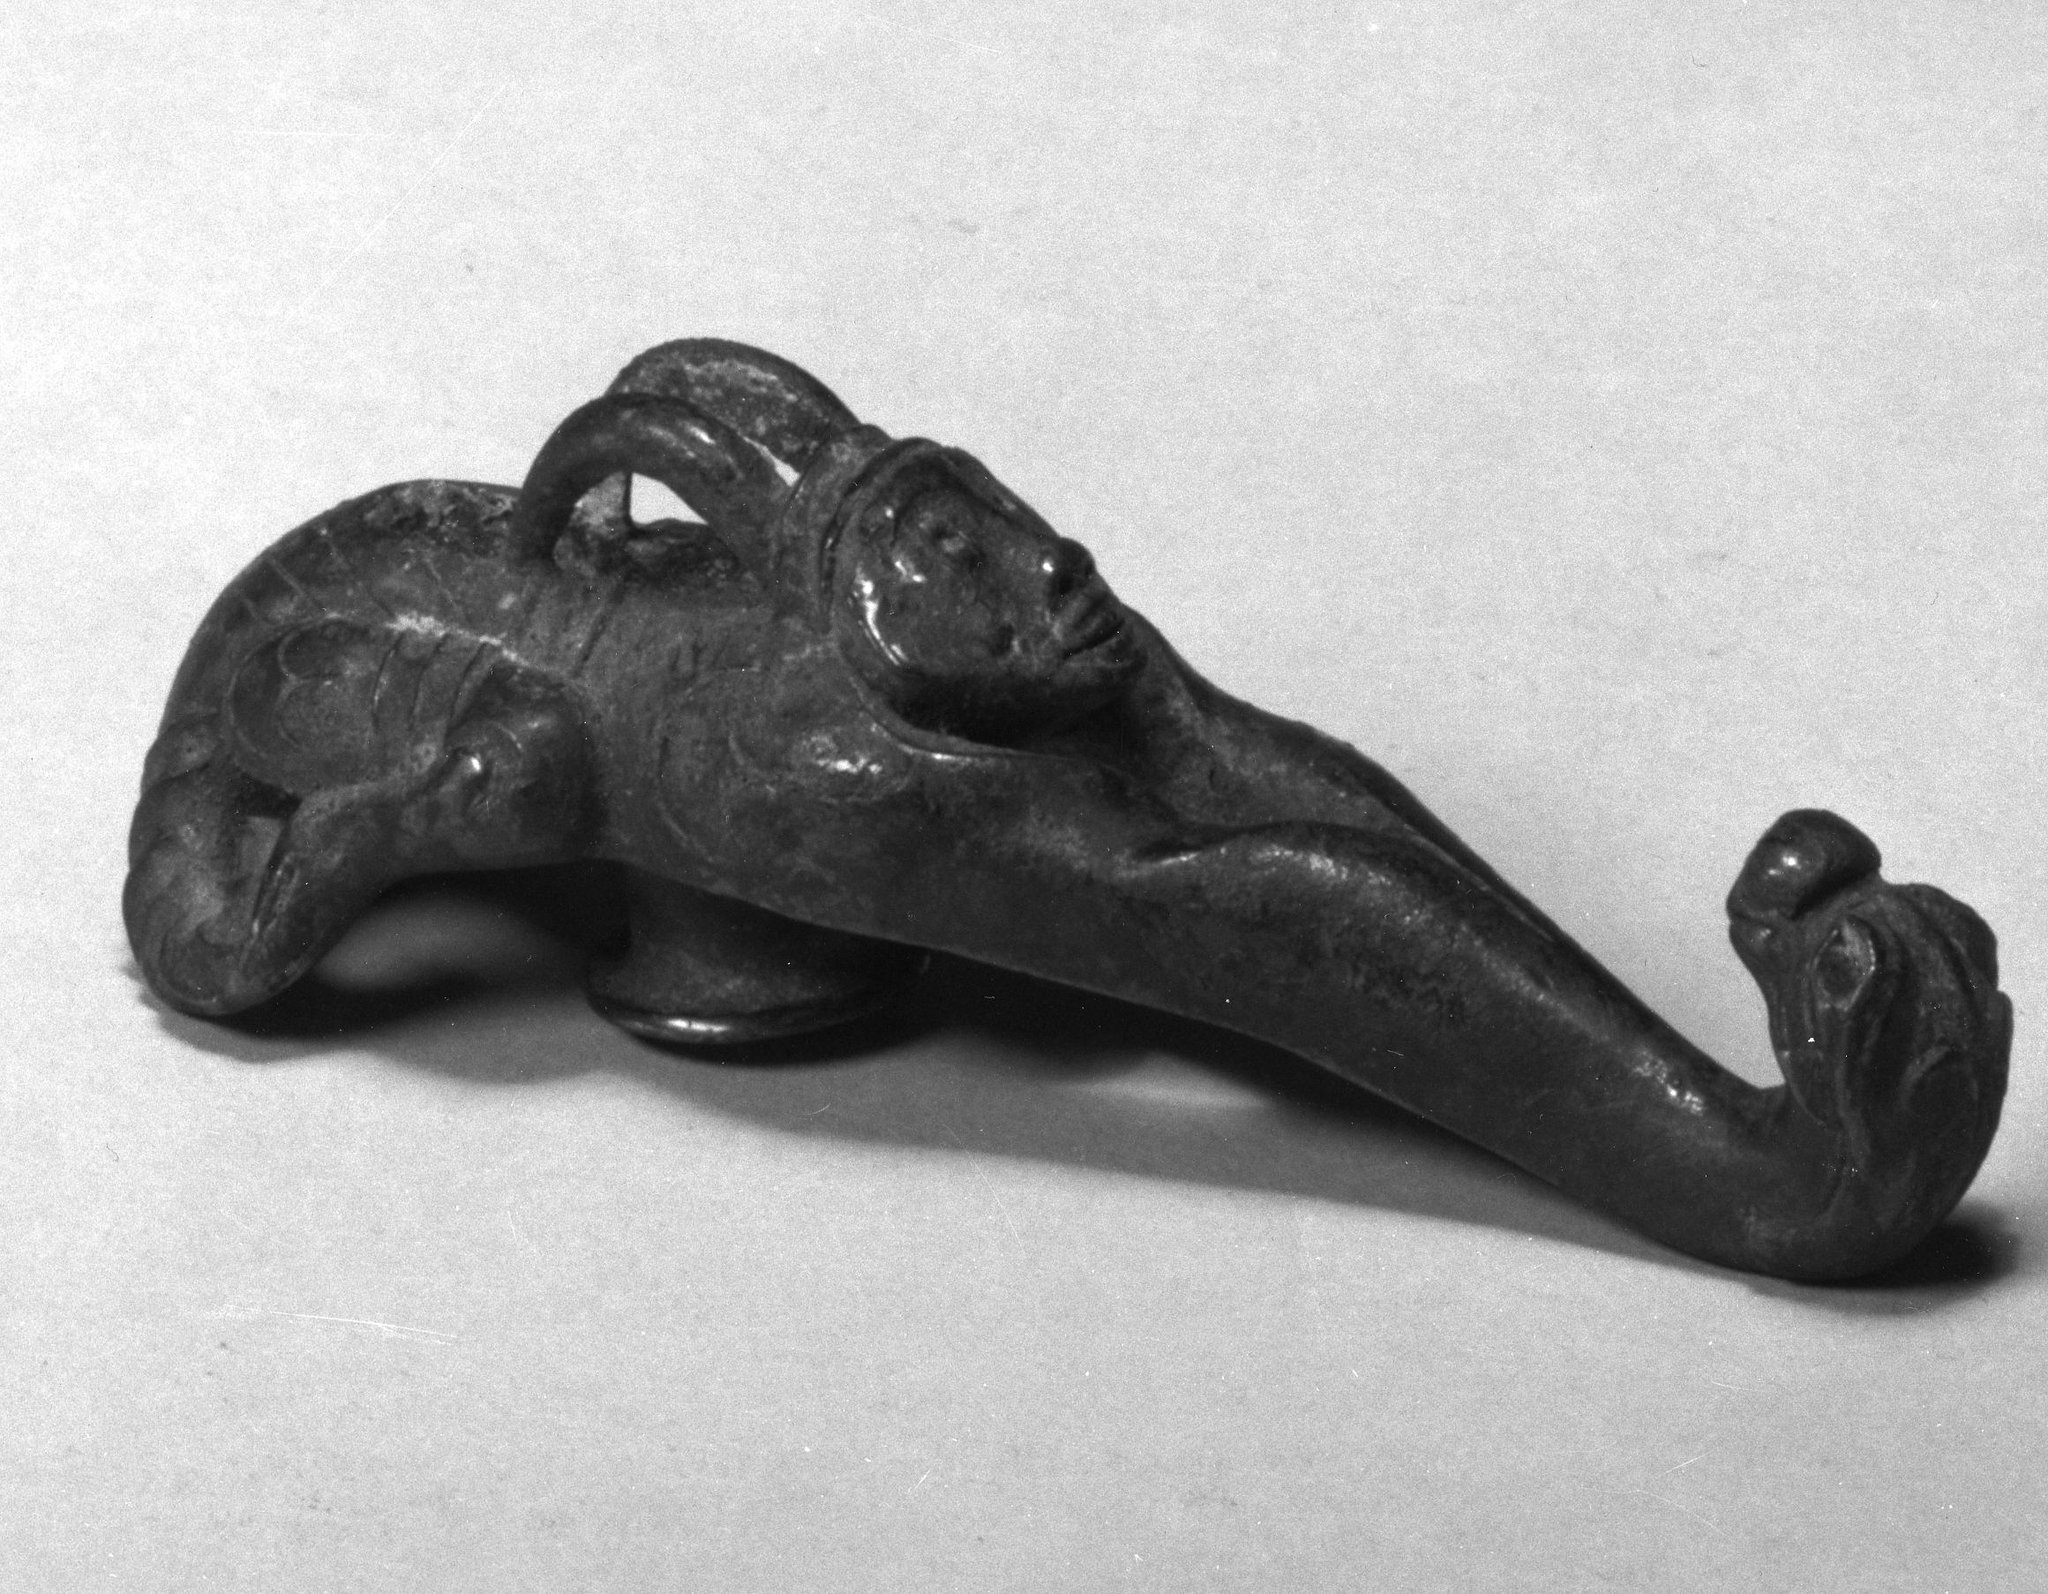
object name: belt buckle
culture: chinese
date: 10000 BCE-1644 CE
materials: bronze